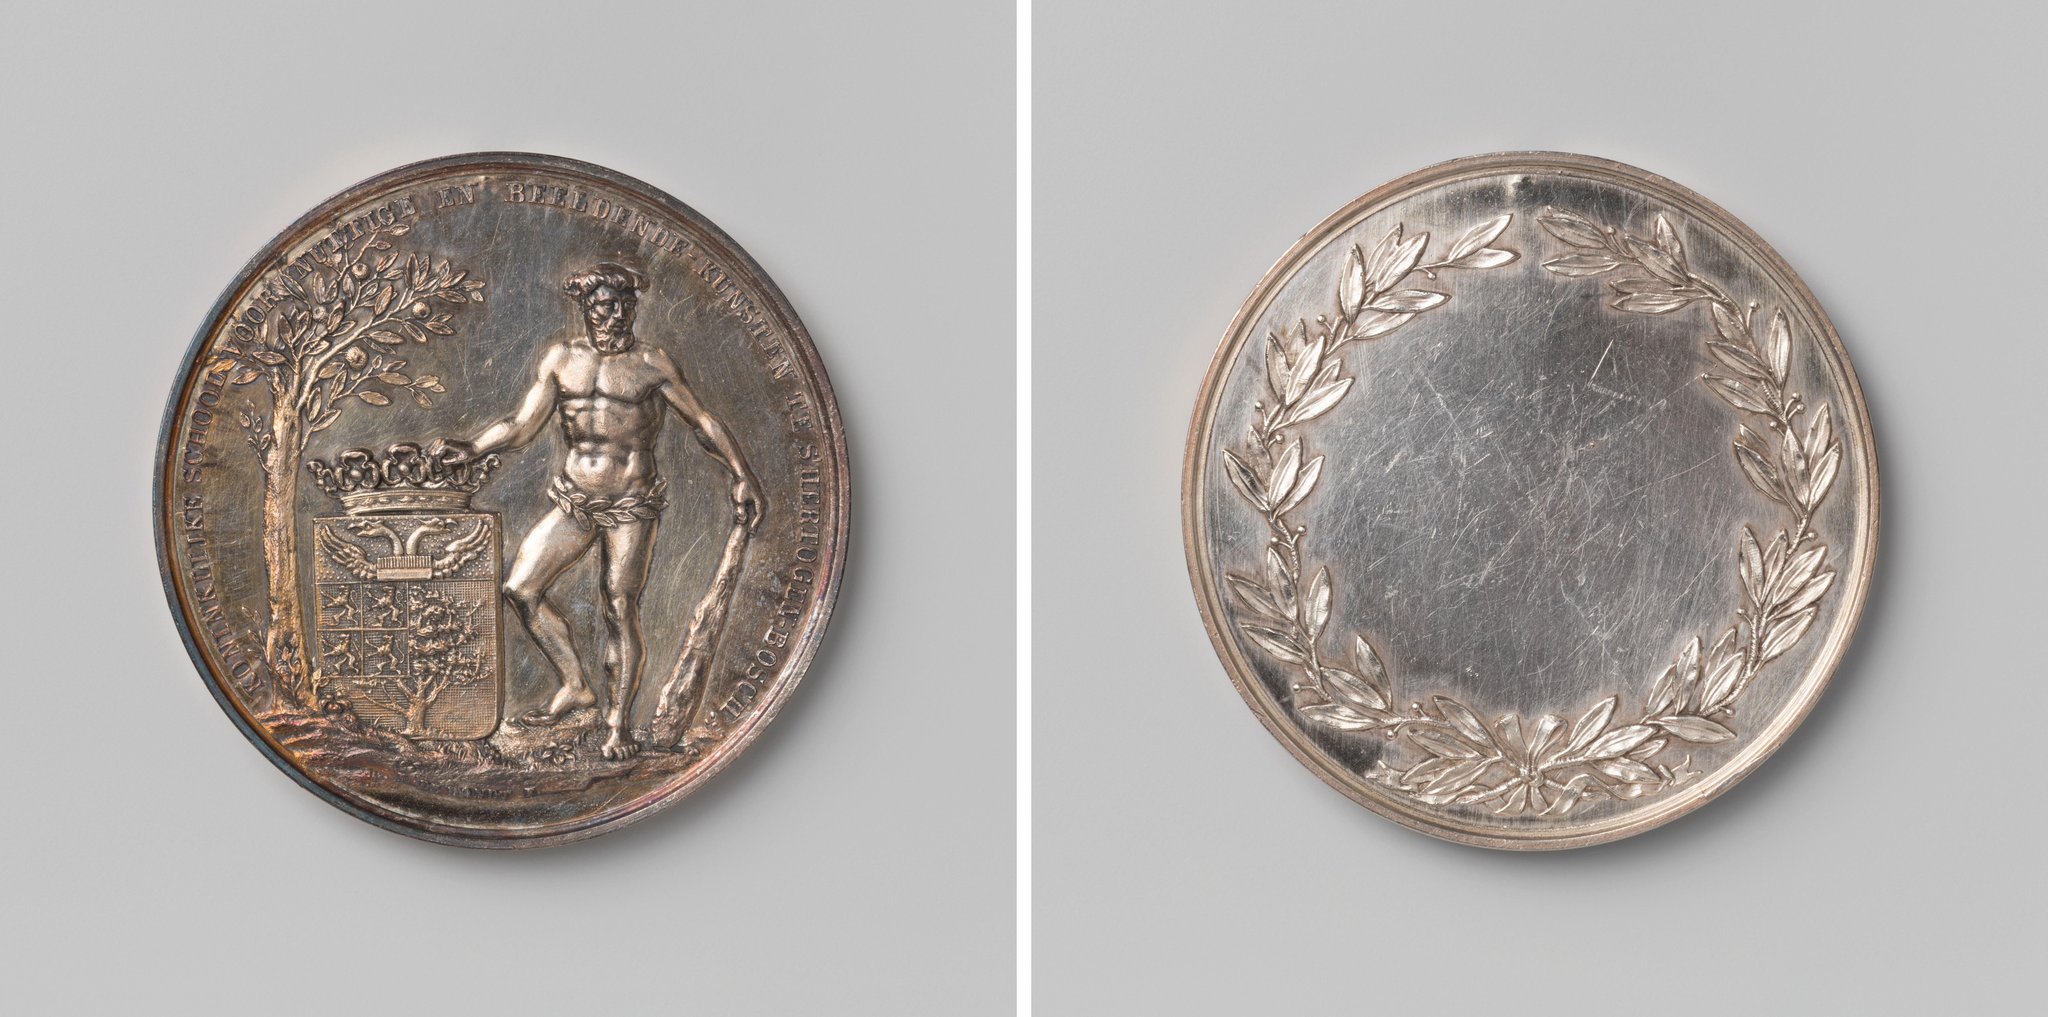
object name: medal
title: Koninklijke school voor nuttige en beeldende kunsten te 's-Hertogenbosch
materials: silver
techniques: striking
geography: bruges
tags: den bosch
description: Zilveren penning. Voorzijde: half naakte wildeman, met linkerhand steunend op knots, met rechterhand op gekroond wapenschild, dat aan voet van vruchtdragende oranjeboom staat binnen omschrift. Keerzijde: blanco veld binnen lauwerkrans